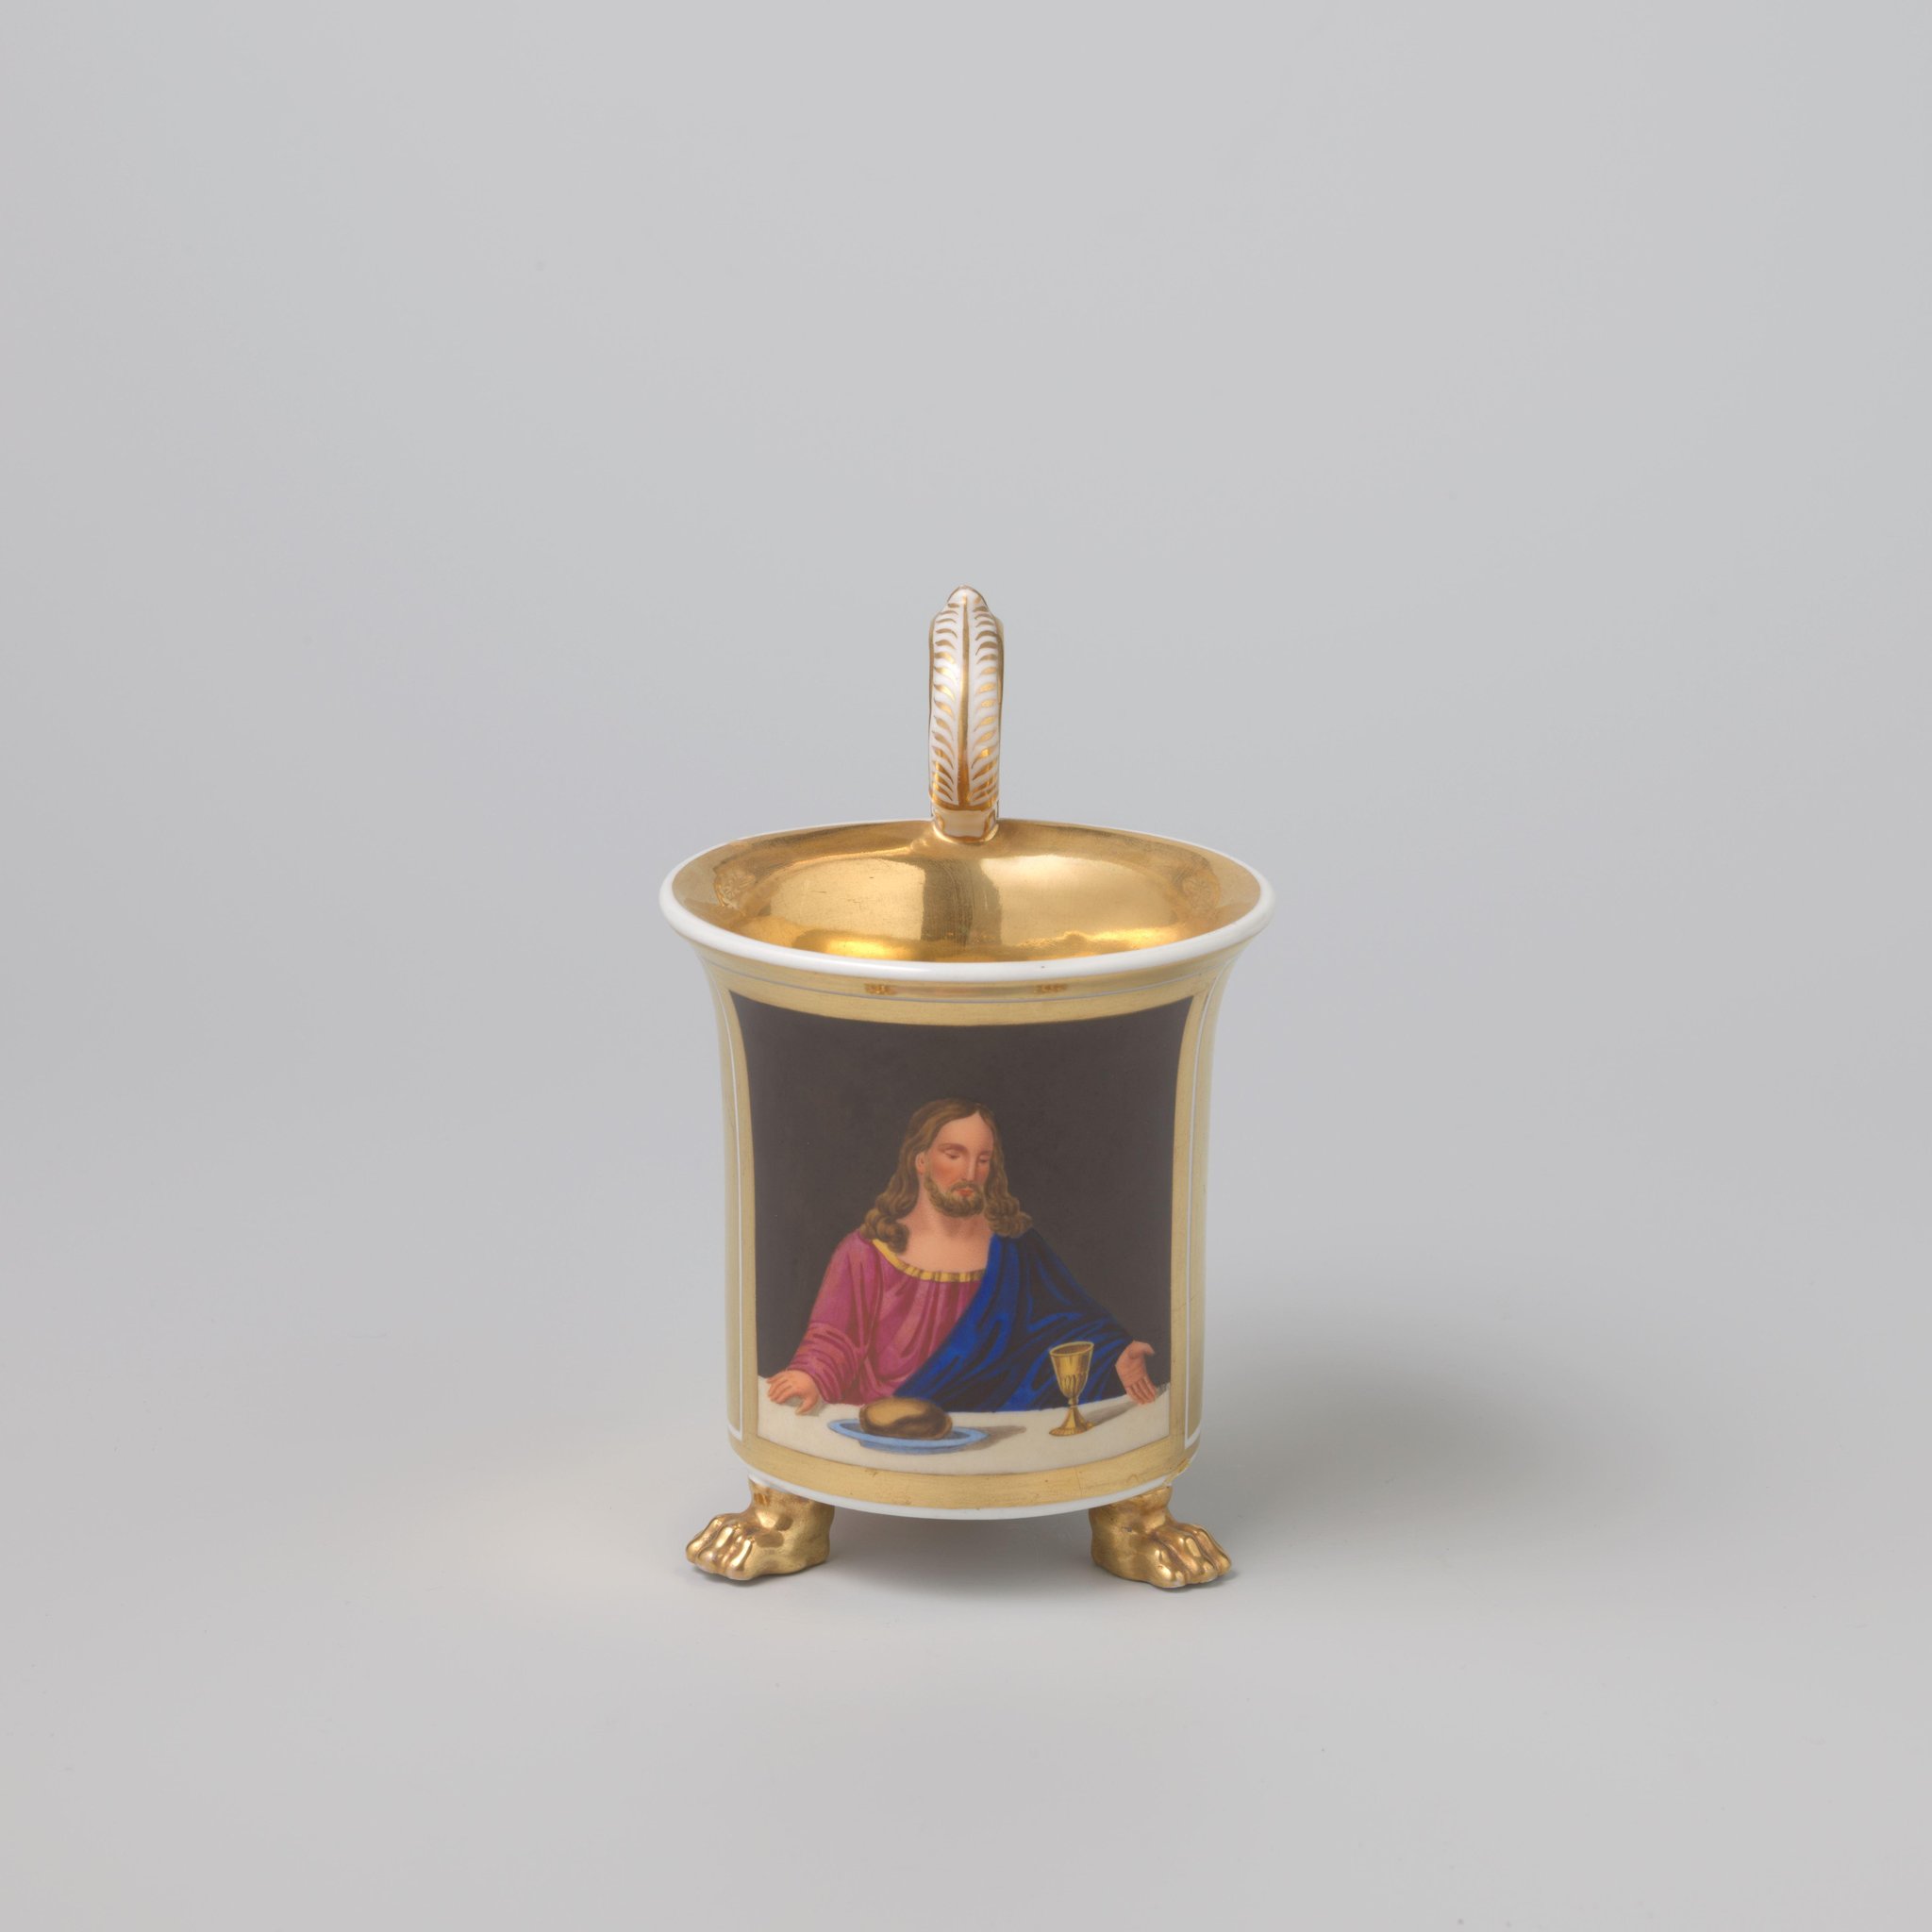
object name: cup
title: Cup with an image of Christ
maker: Anonymous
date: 1842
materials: glaze, gold, paint, porcelain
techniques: firing, forming, gilding, relief, turning, vitrification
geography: europe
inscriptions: mark: ‘zwaard of f’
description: Te hoge, rijk vergulde kop rustend op drie klauwpootjes is aan de voorzijde beschilderd met de figuur van Christus bij het Laatste Avondmaal. Christus ten halven lijve gezien, is gekleed in een rood gewaad met blauwe mantel. Op de door een wit kleed bedekte tafel staat een blauwe schaal met brood en een kelk met wijn. De achtergrond is donkerbruin. Ook de binnenzijde van de kop is verguld. Op de bodem enkele cirkels in goud op witte grond. Het oor steekt hoog boven de kop uit en vertoont een rozet.